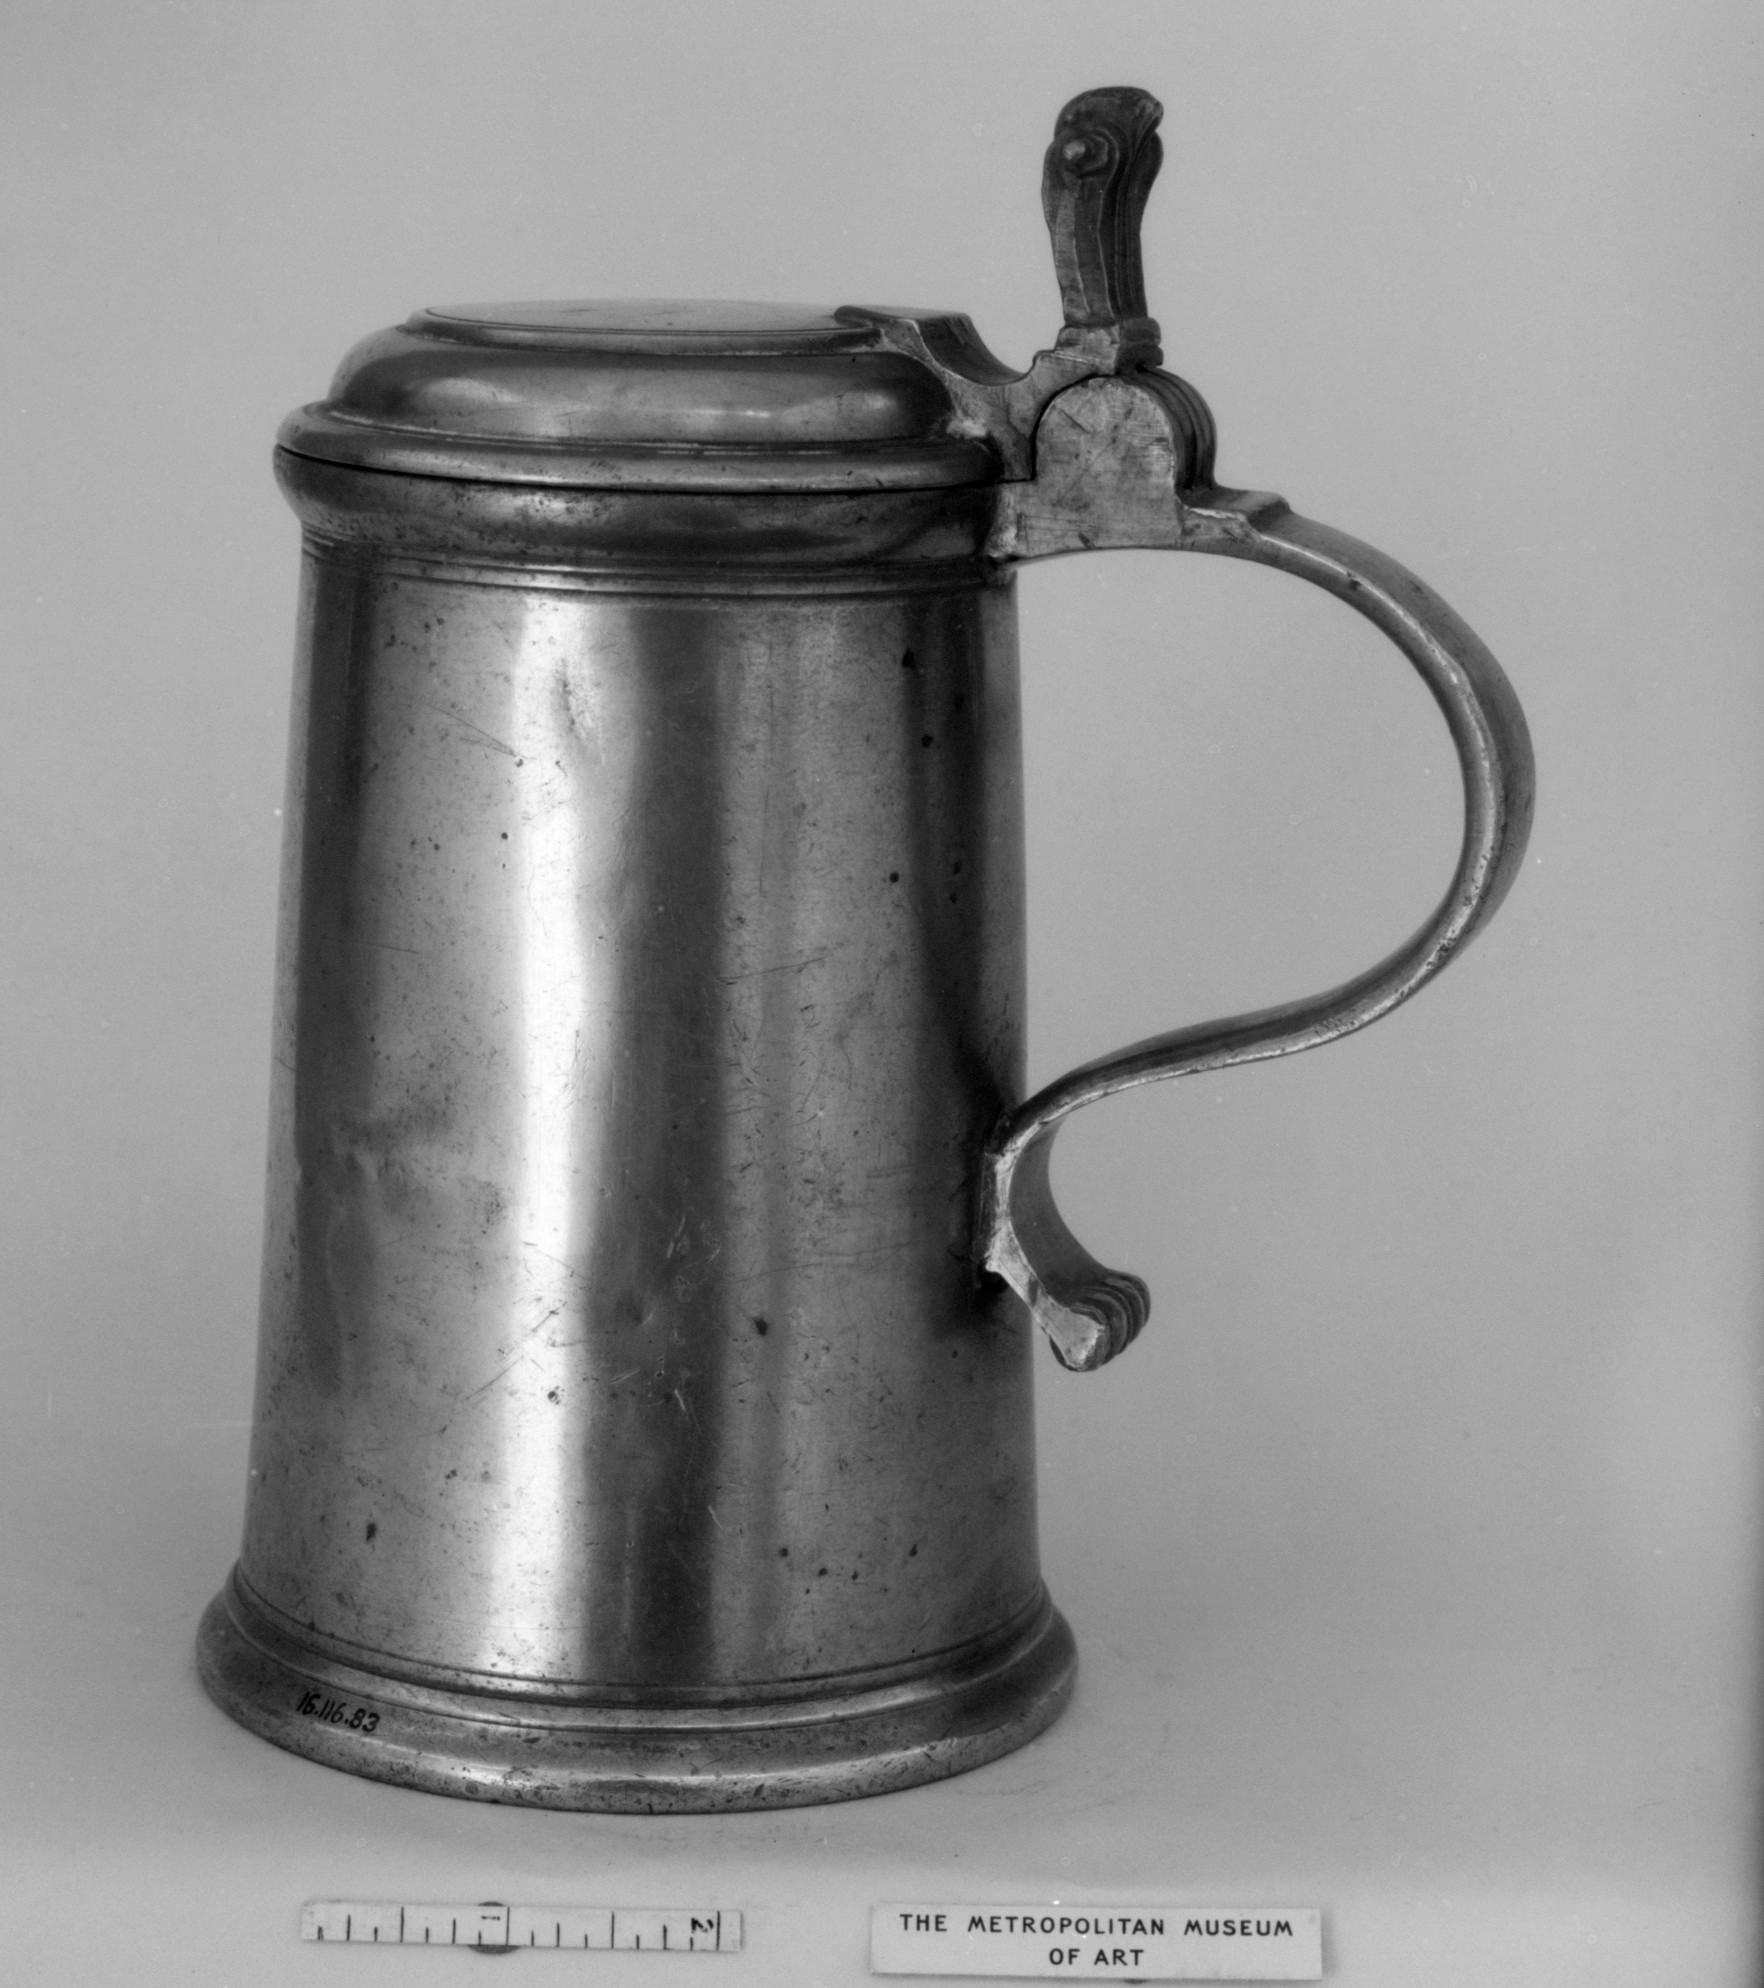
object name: tankard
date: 1601-1800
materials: pewter